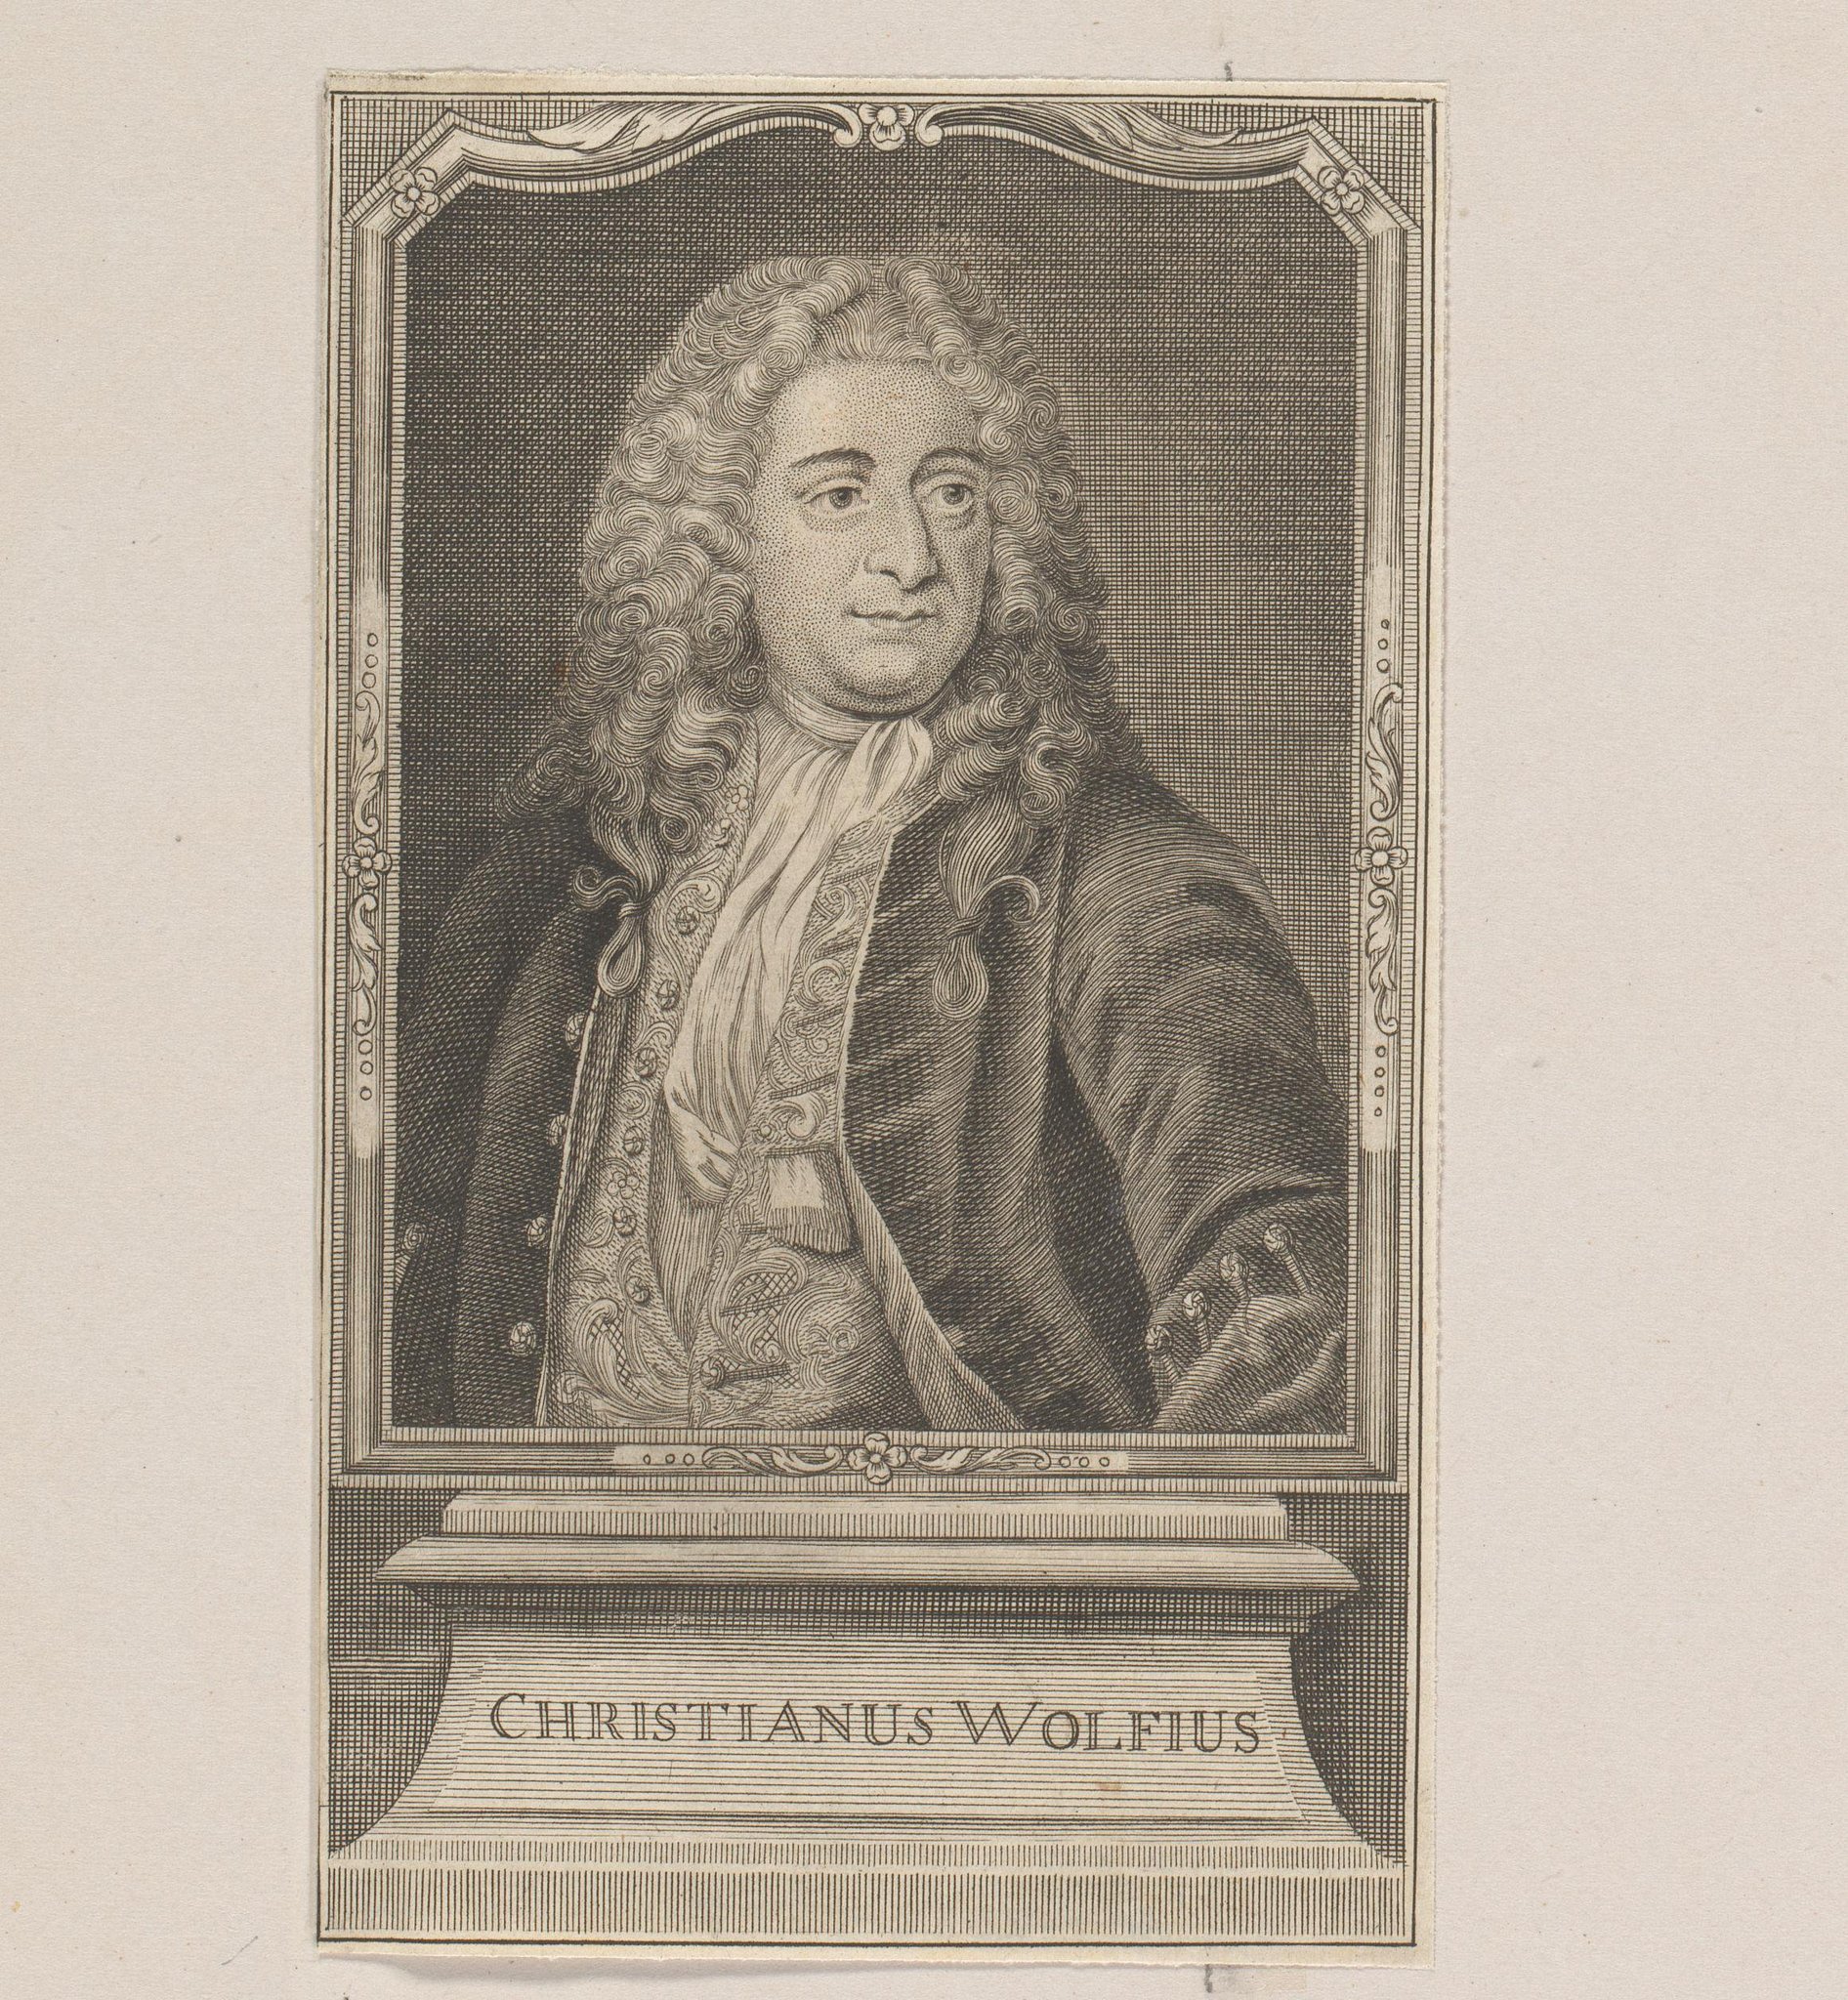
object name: print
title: Portret van Christian Wolff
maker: Anonymous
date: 1750-1799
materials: paper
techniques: engraving, etching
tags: scholar, philosopher, historical persons